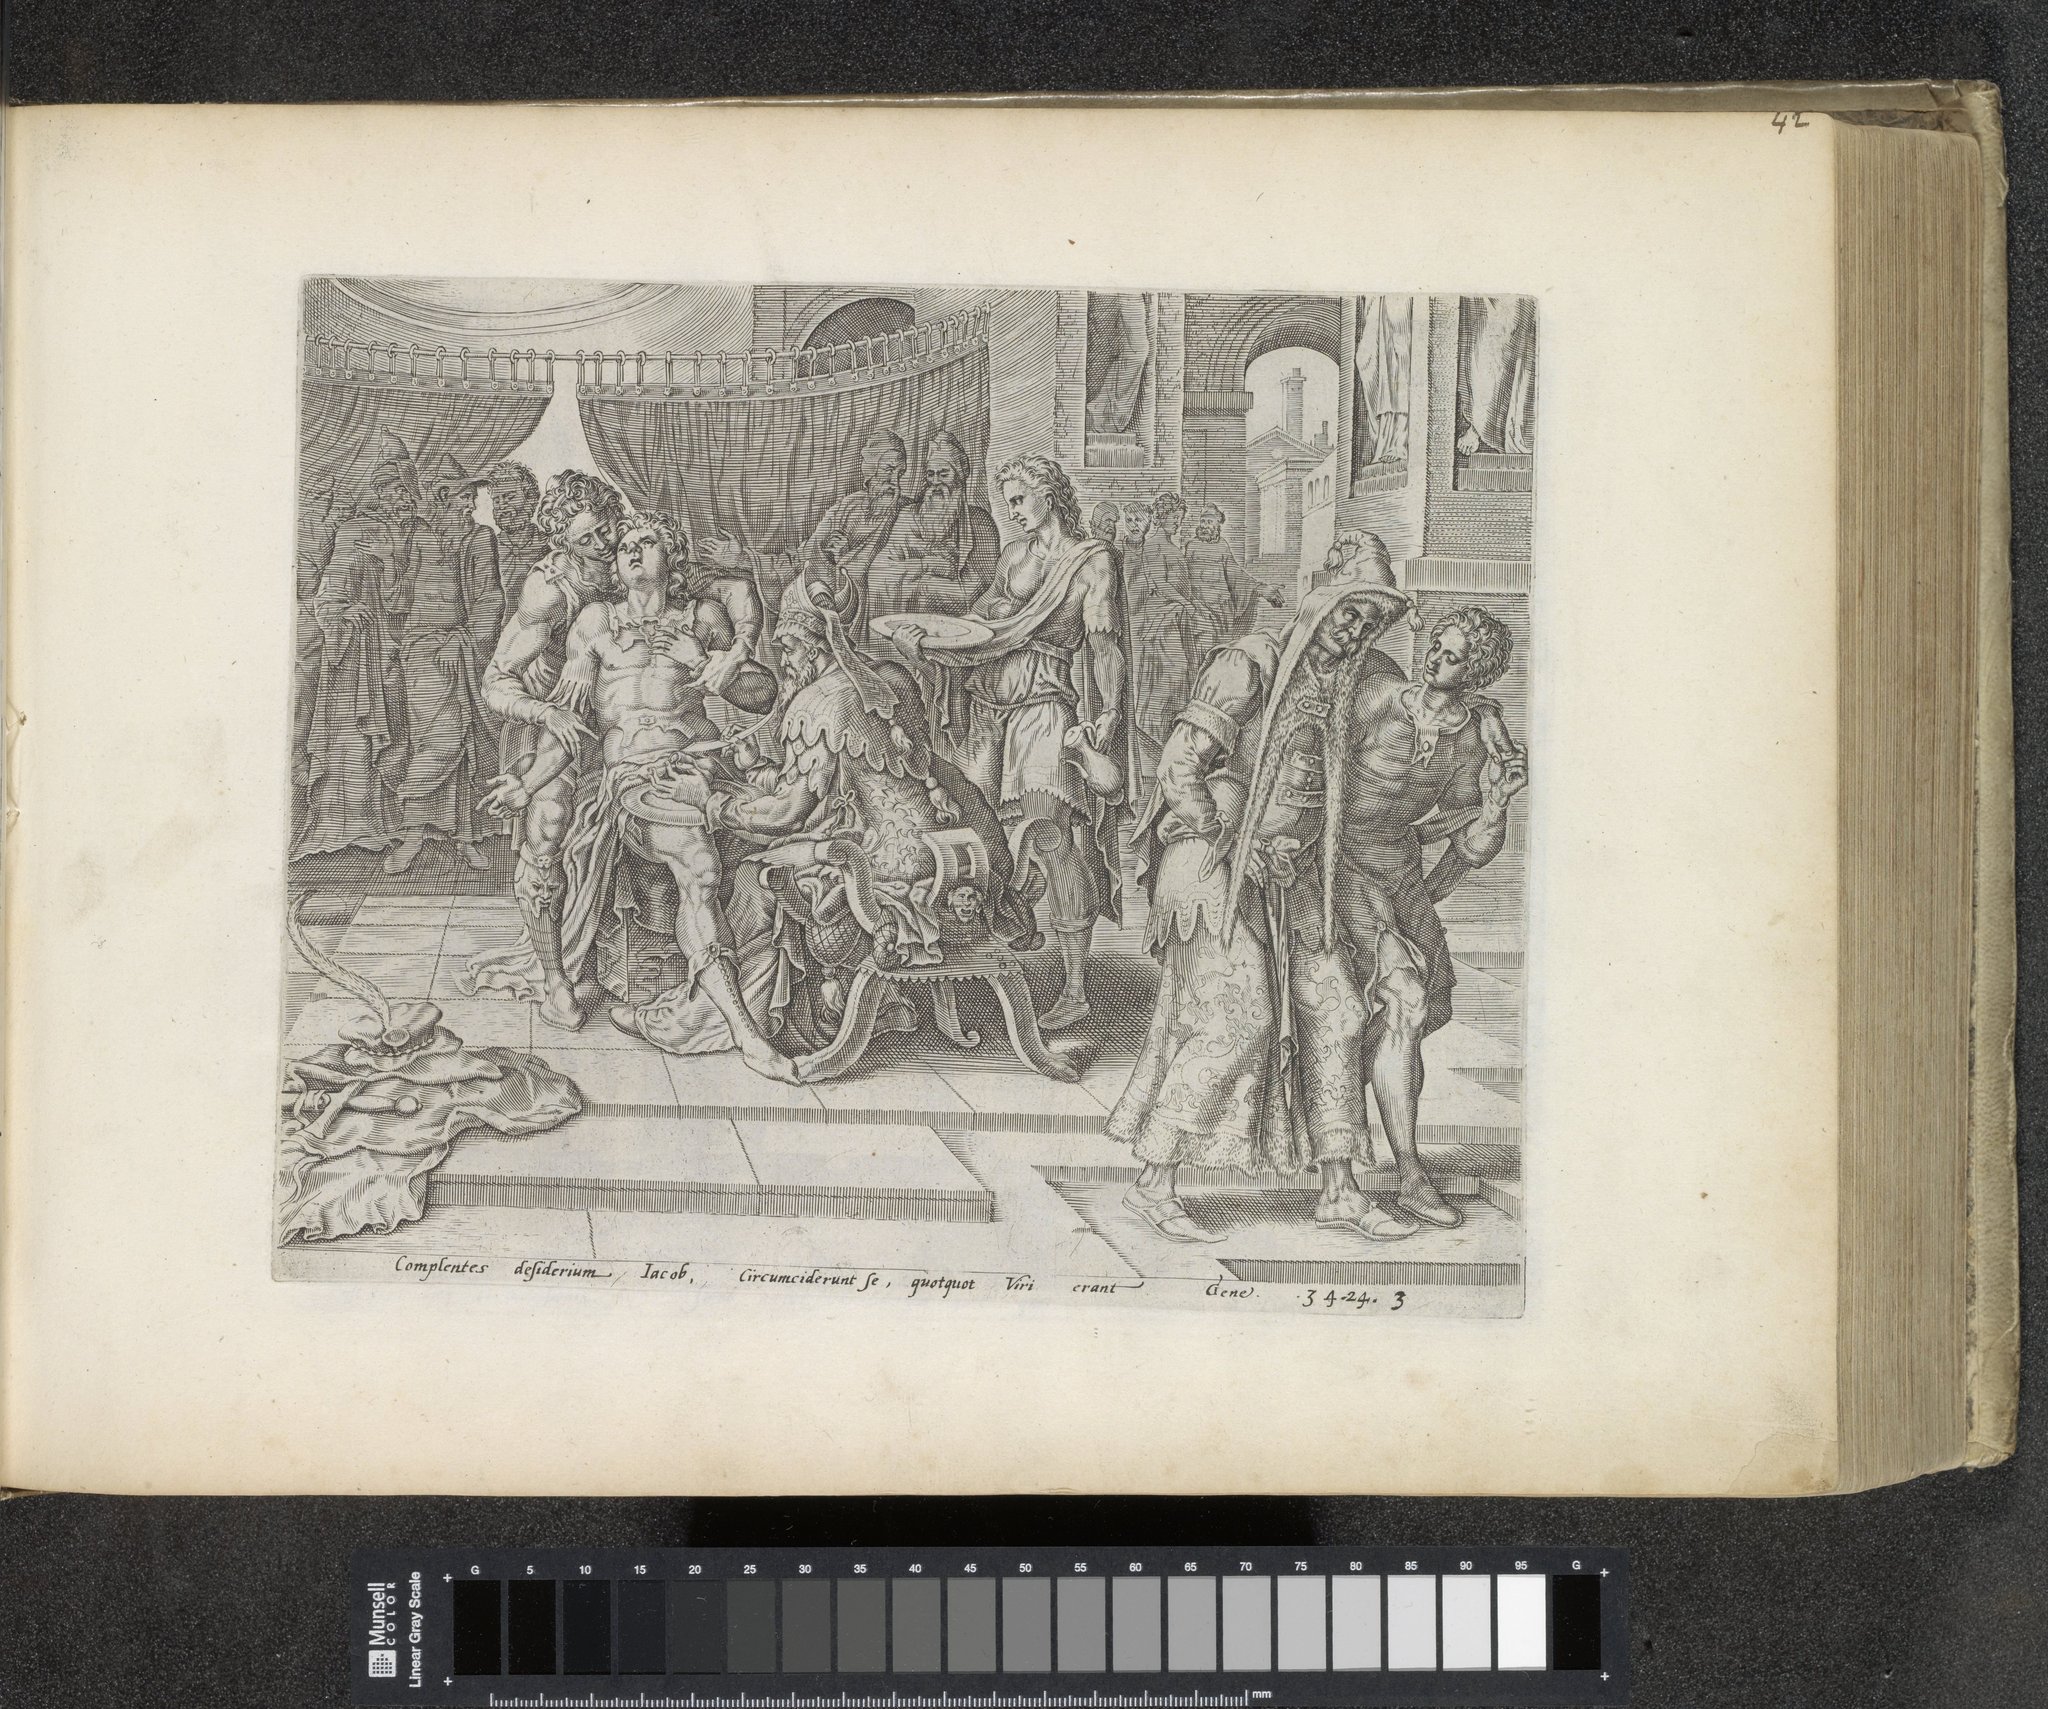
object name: album leaf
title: Theatrum Biblicum Hoc Est Historiae Sacrae Veteris et Novi Testamenti Tabulis Aeneis Expressae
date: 1585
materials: paper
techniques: engraving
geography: amsterdam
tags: shechem and hamor propose the circumcision to their fellow-townsmen (+ variant)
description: Sichem wordt besneden. Rechts wordt de zojuist besneden Chamor, de vader van Sichem, door een jongen ondersteund. Onderaan in de marge een verwijzing in het Latijn naar de Bijbeltekst in Gen. 34:24. Deze prent maakt deel uit van een album.